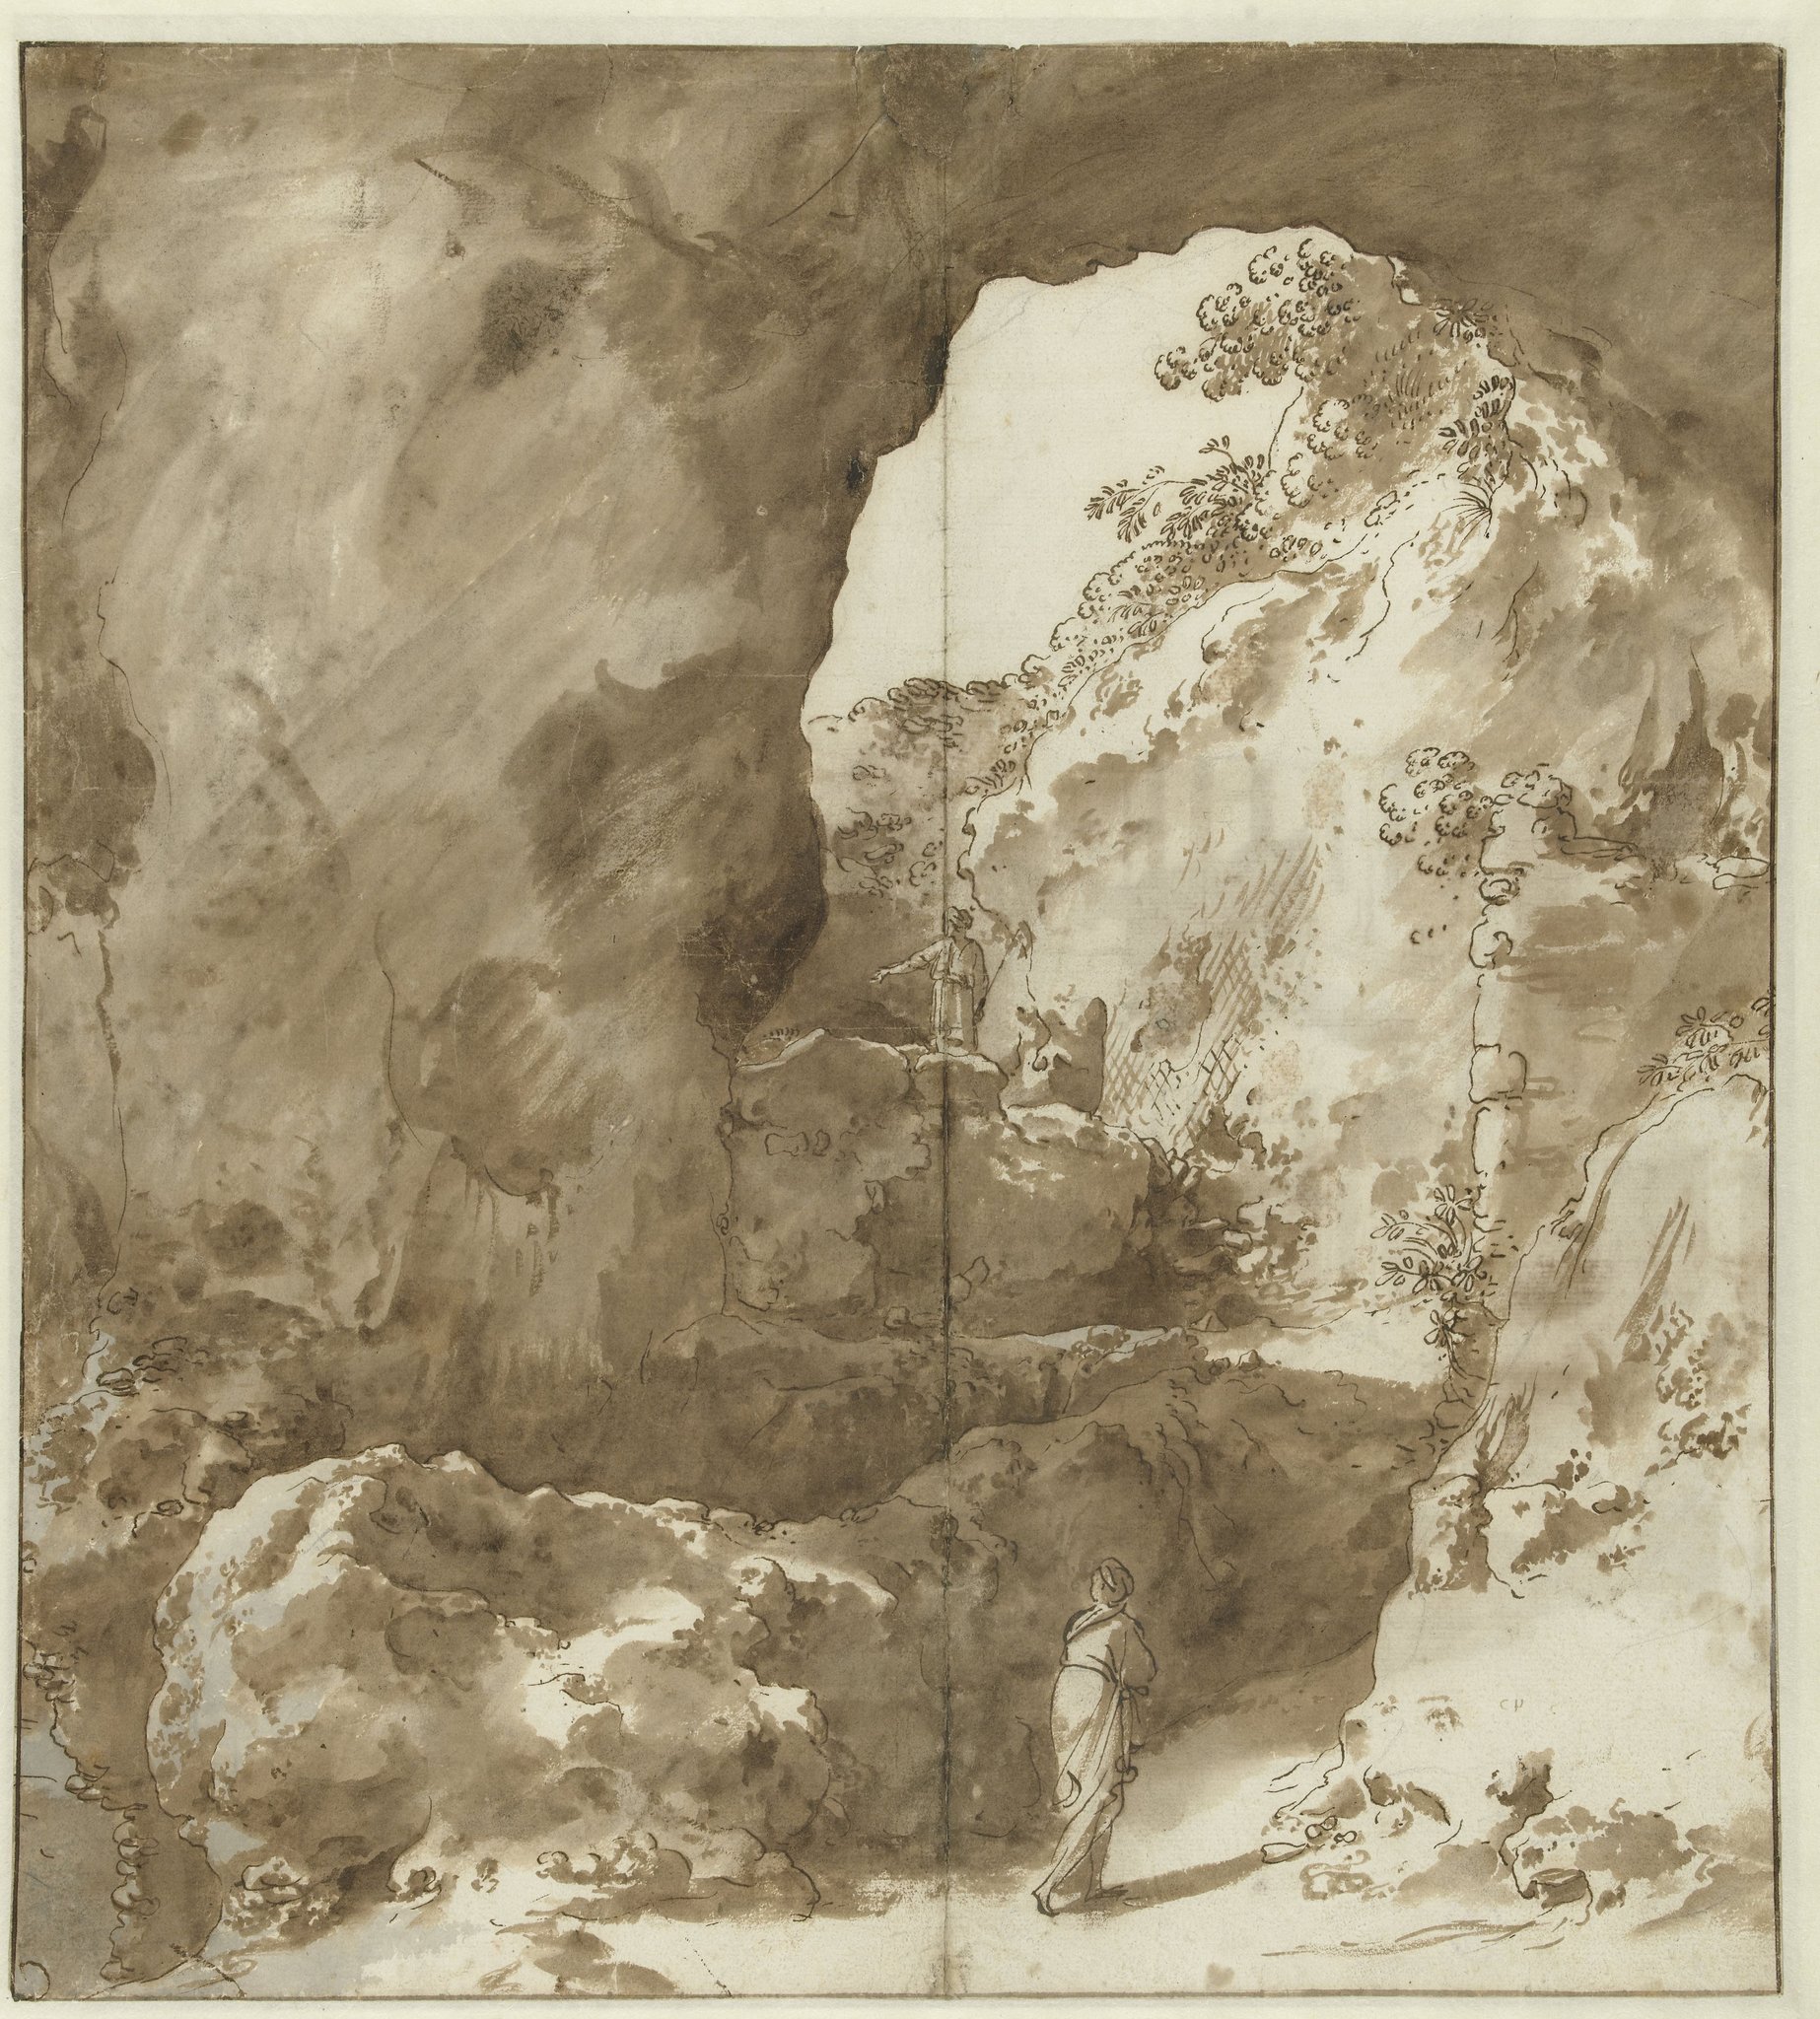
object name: drawing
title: Interieur van een ruïne met figuren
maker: cornelis van poelenburch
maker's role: draughtsman, painter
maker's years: 1594-1667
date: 1596-1667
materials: chalk, paper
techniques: brush, pen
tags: ruin of a building ~ architecture, italy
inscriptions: monogram: ‘CP’